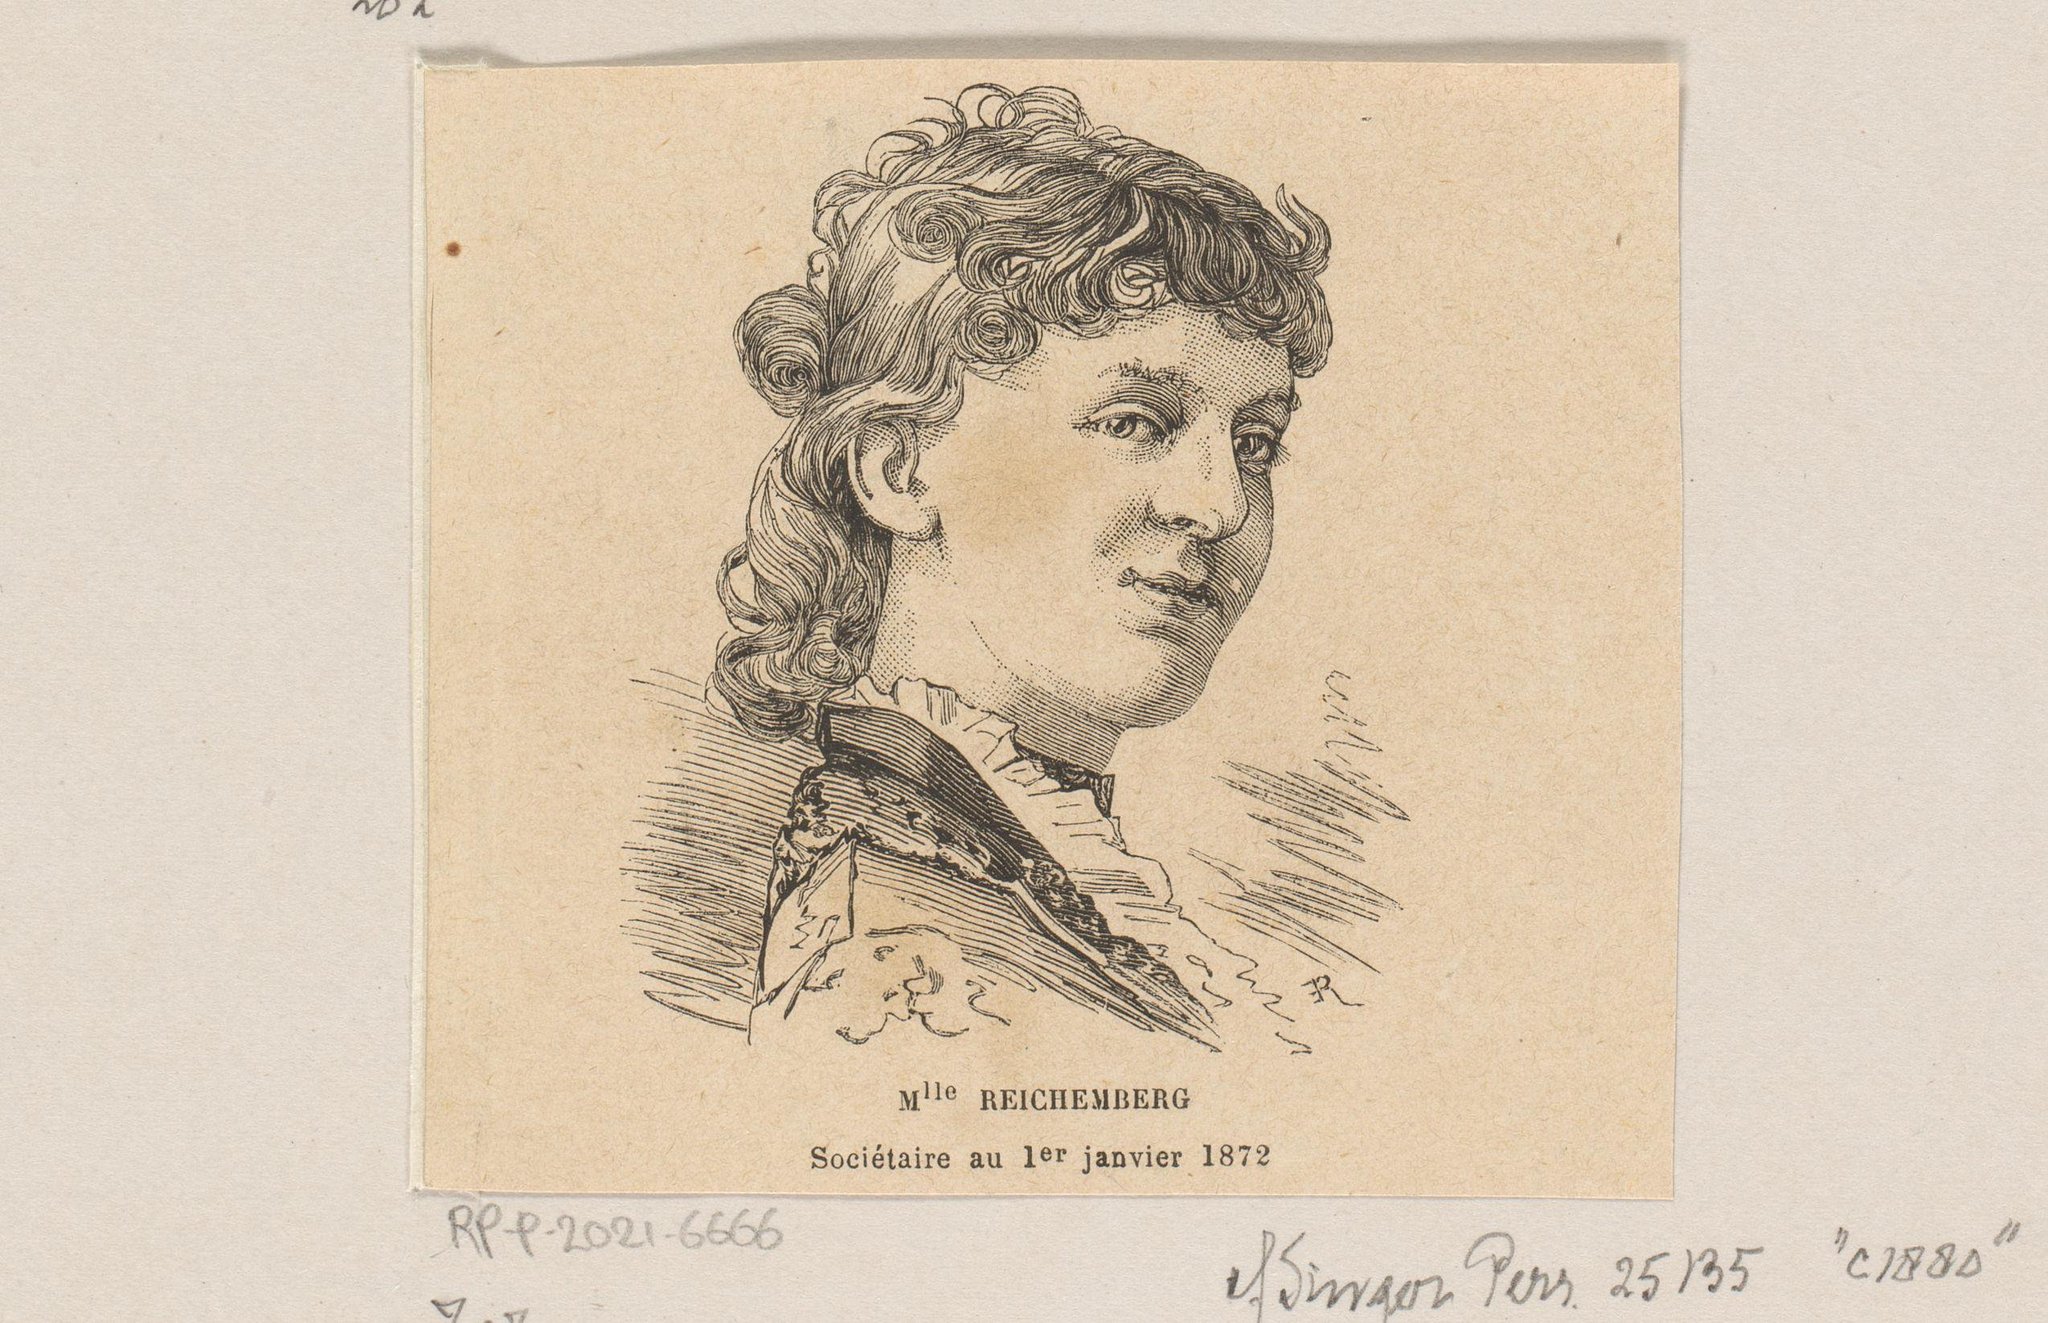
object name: print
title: Portret van Suzanne Reichemberg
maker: Anonymous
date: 1872-1899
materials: paper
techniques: letterpress printing, engraving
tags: historical persons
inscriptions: signature: ‘ER’